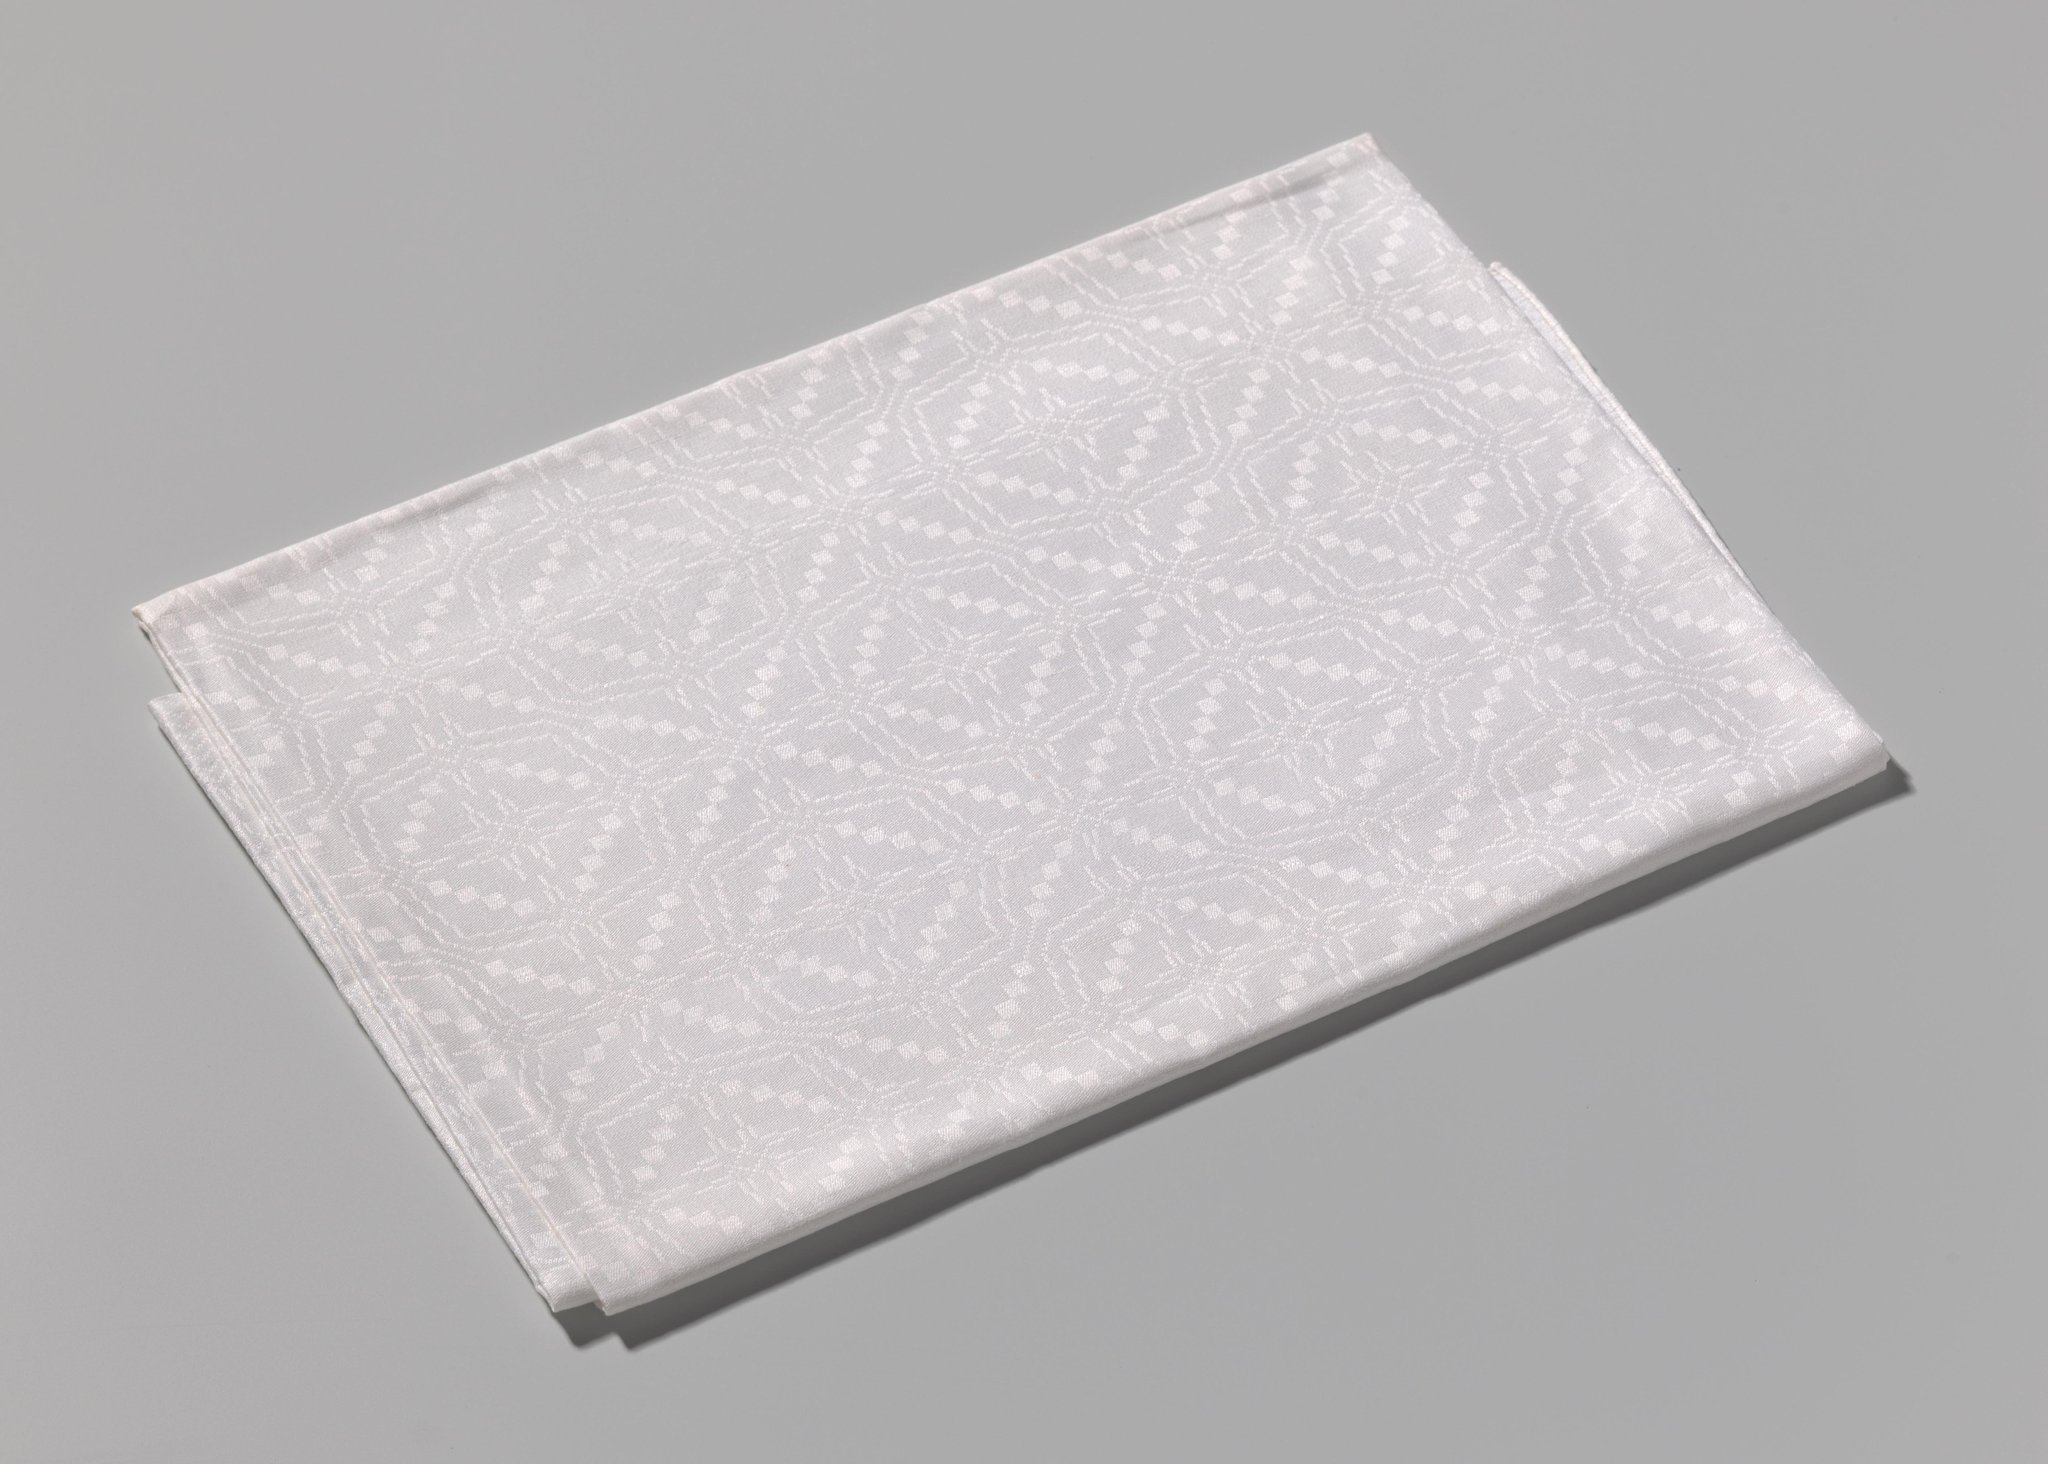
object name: napkin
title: Pellen. Merk: HW 38 p poonl.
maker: Anonymous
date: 1775-1799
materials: linen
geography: netherlands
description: Servet van wit linnen met een pellen patroon en randen, merk HW 38 p poonl.